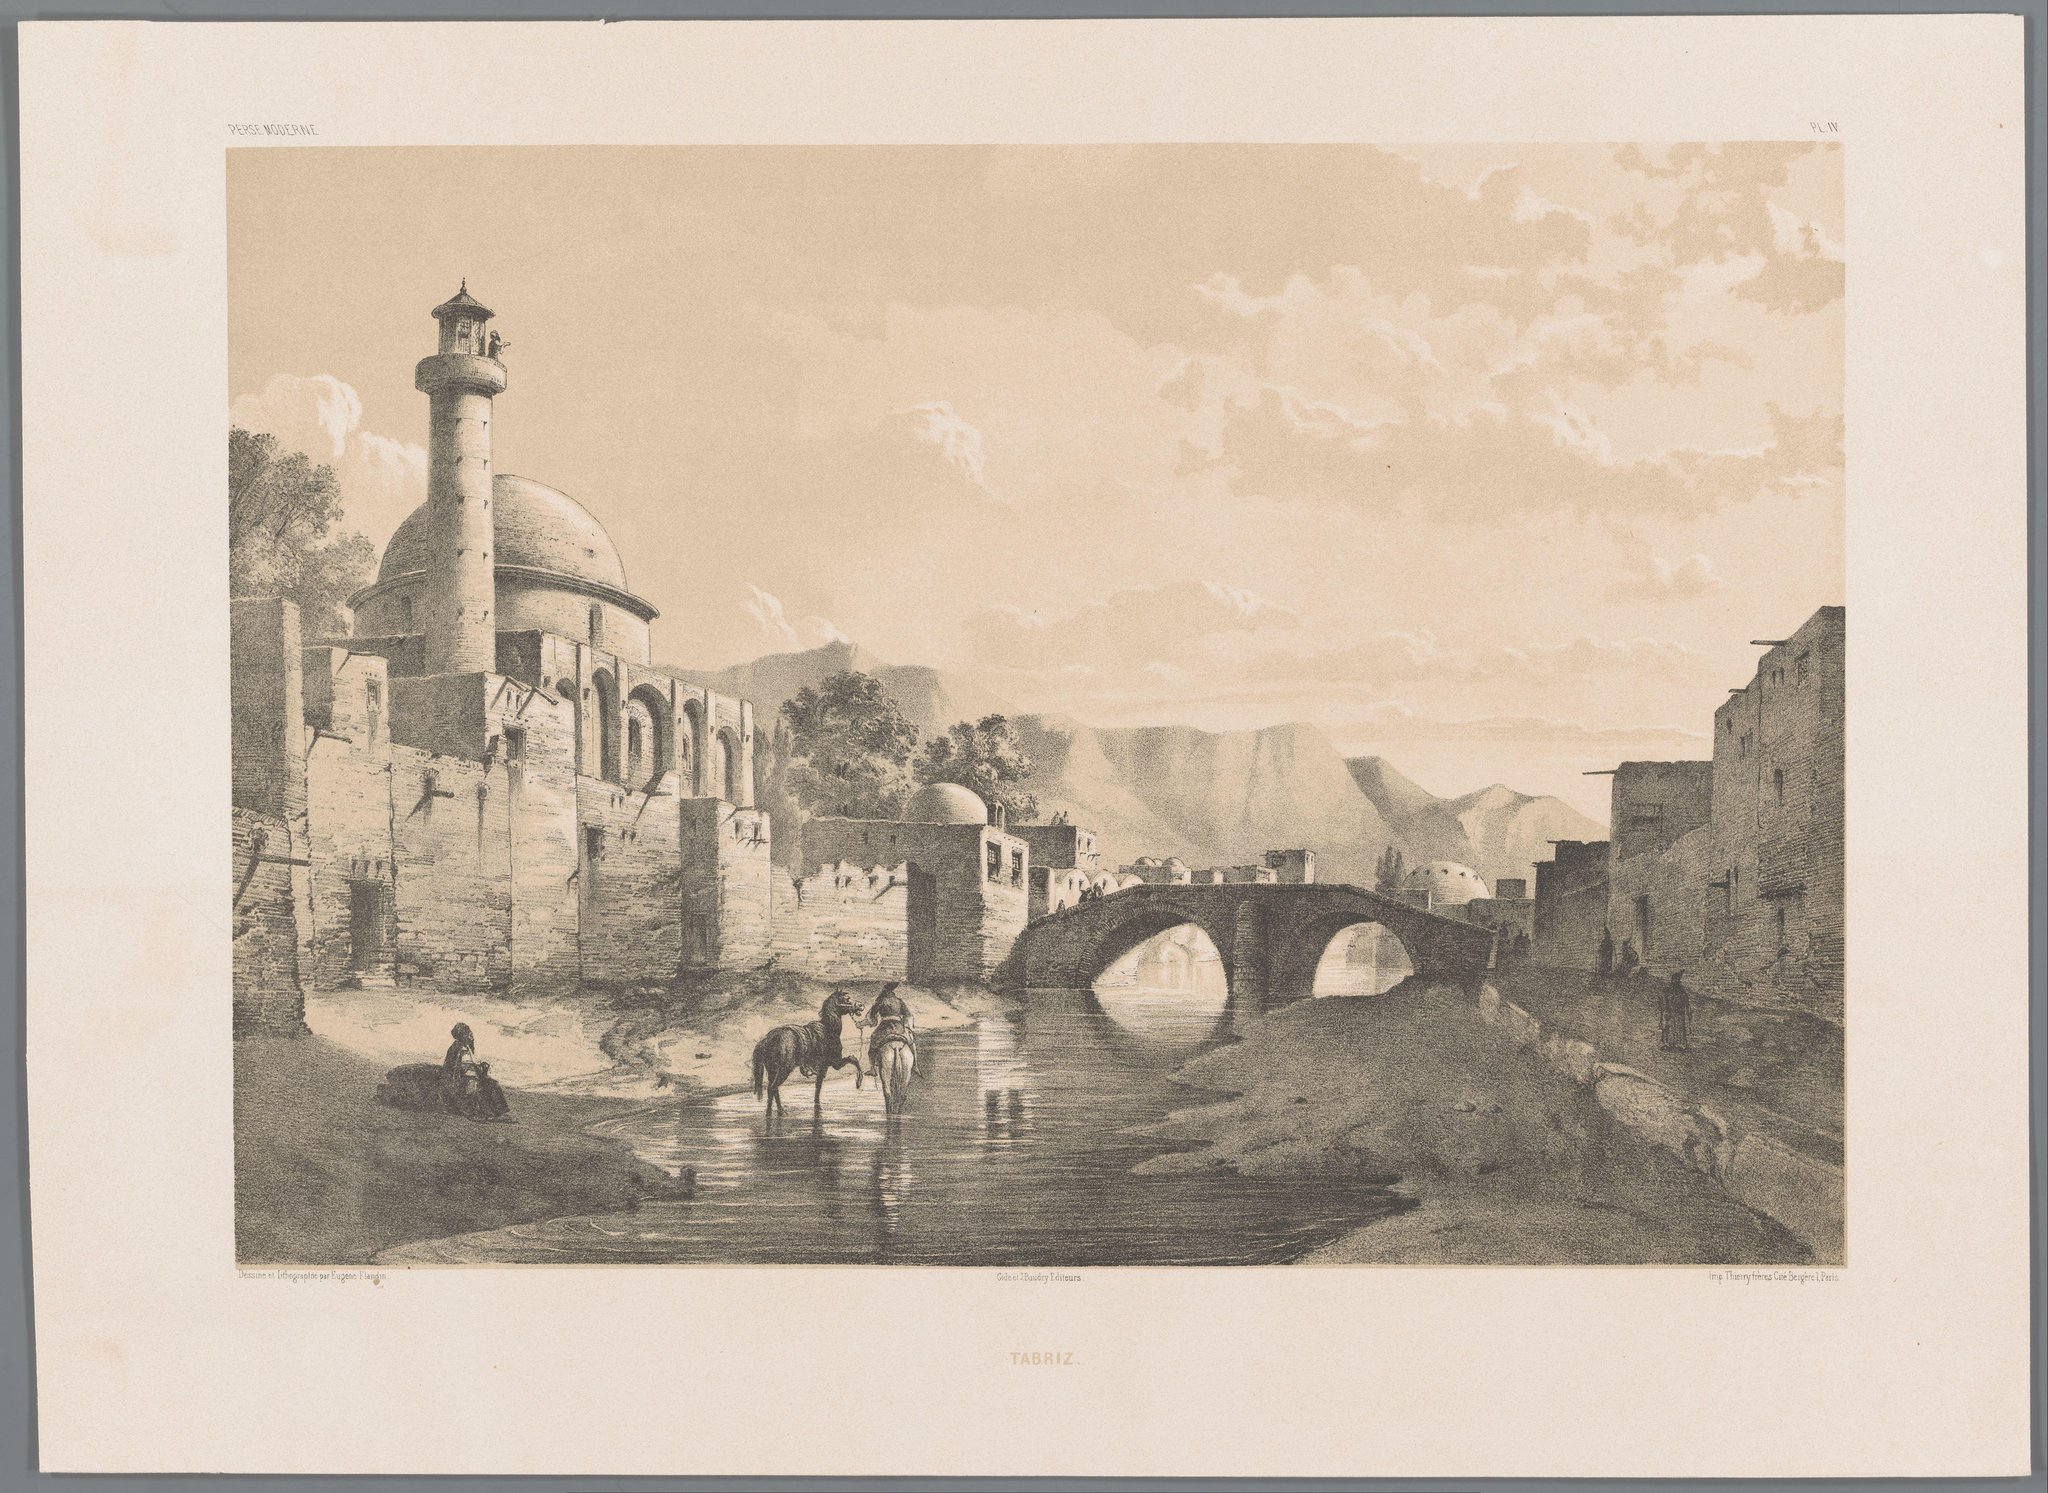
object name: print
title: Tabriz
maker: eugène flandin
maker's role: painter, print maker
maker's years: 1809-1889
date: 1843-1854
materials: paper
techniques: tone lithography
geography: paris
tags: temple, shrine ~ islam, mohammedanism, bridge in city across river, canal, etc.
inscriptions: collector's mark: Lugt 2228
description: Prent uit: Coste, Pascal-Xavier en Eugène Napoléon Flandin. Voyage en Perse de mm. Eugène Flandin, peintre, et Pascal Coste, architecte (...). 8 dln. Parijs: Gide et Jules Baudry, 1843-1854.